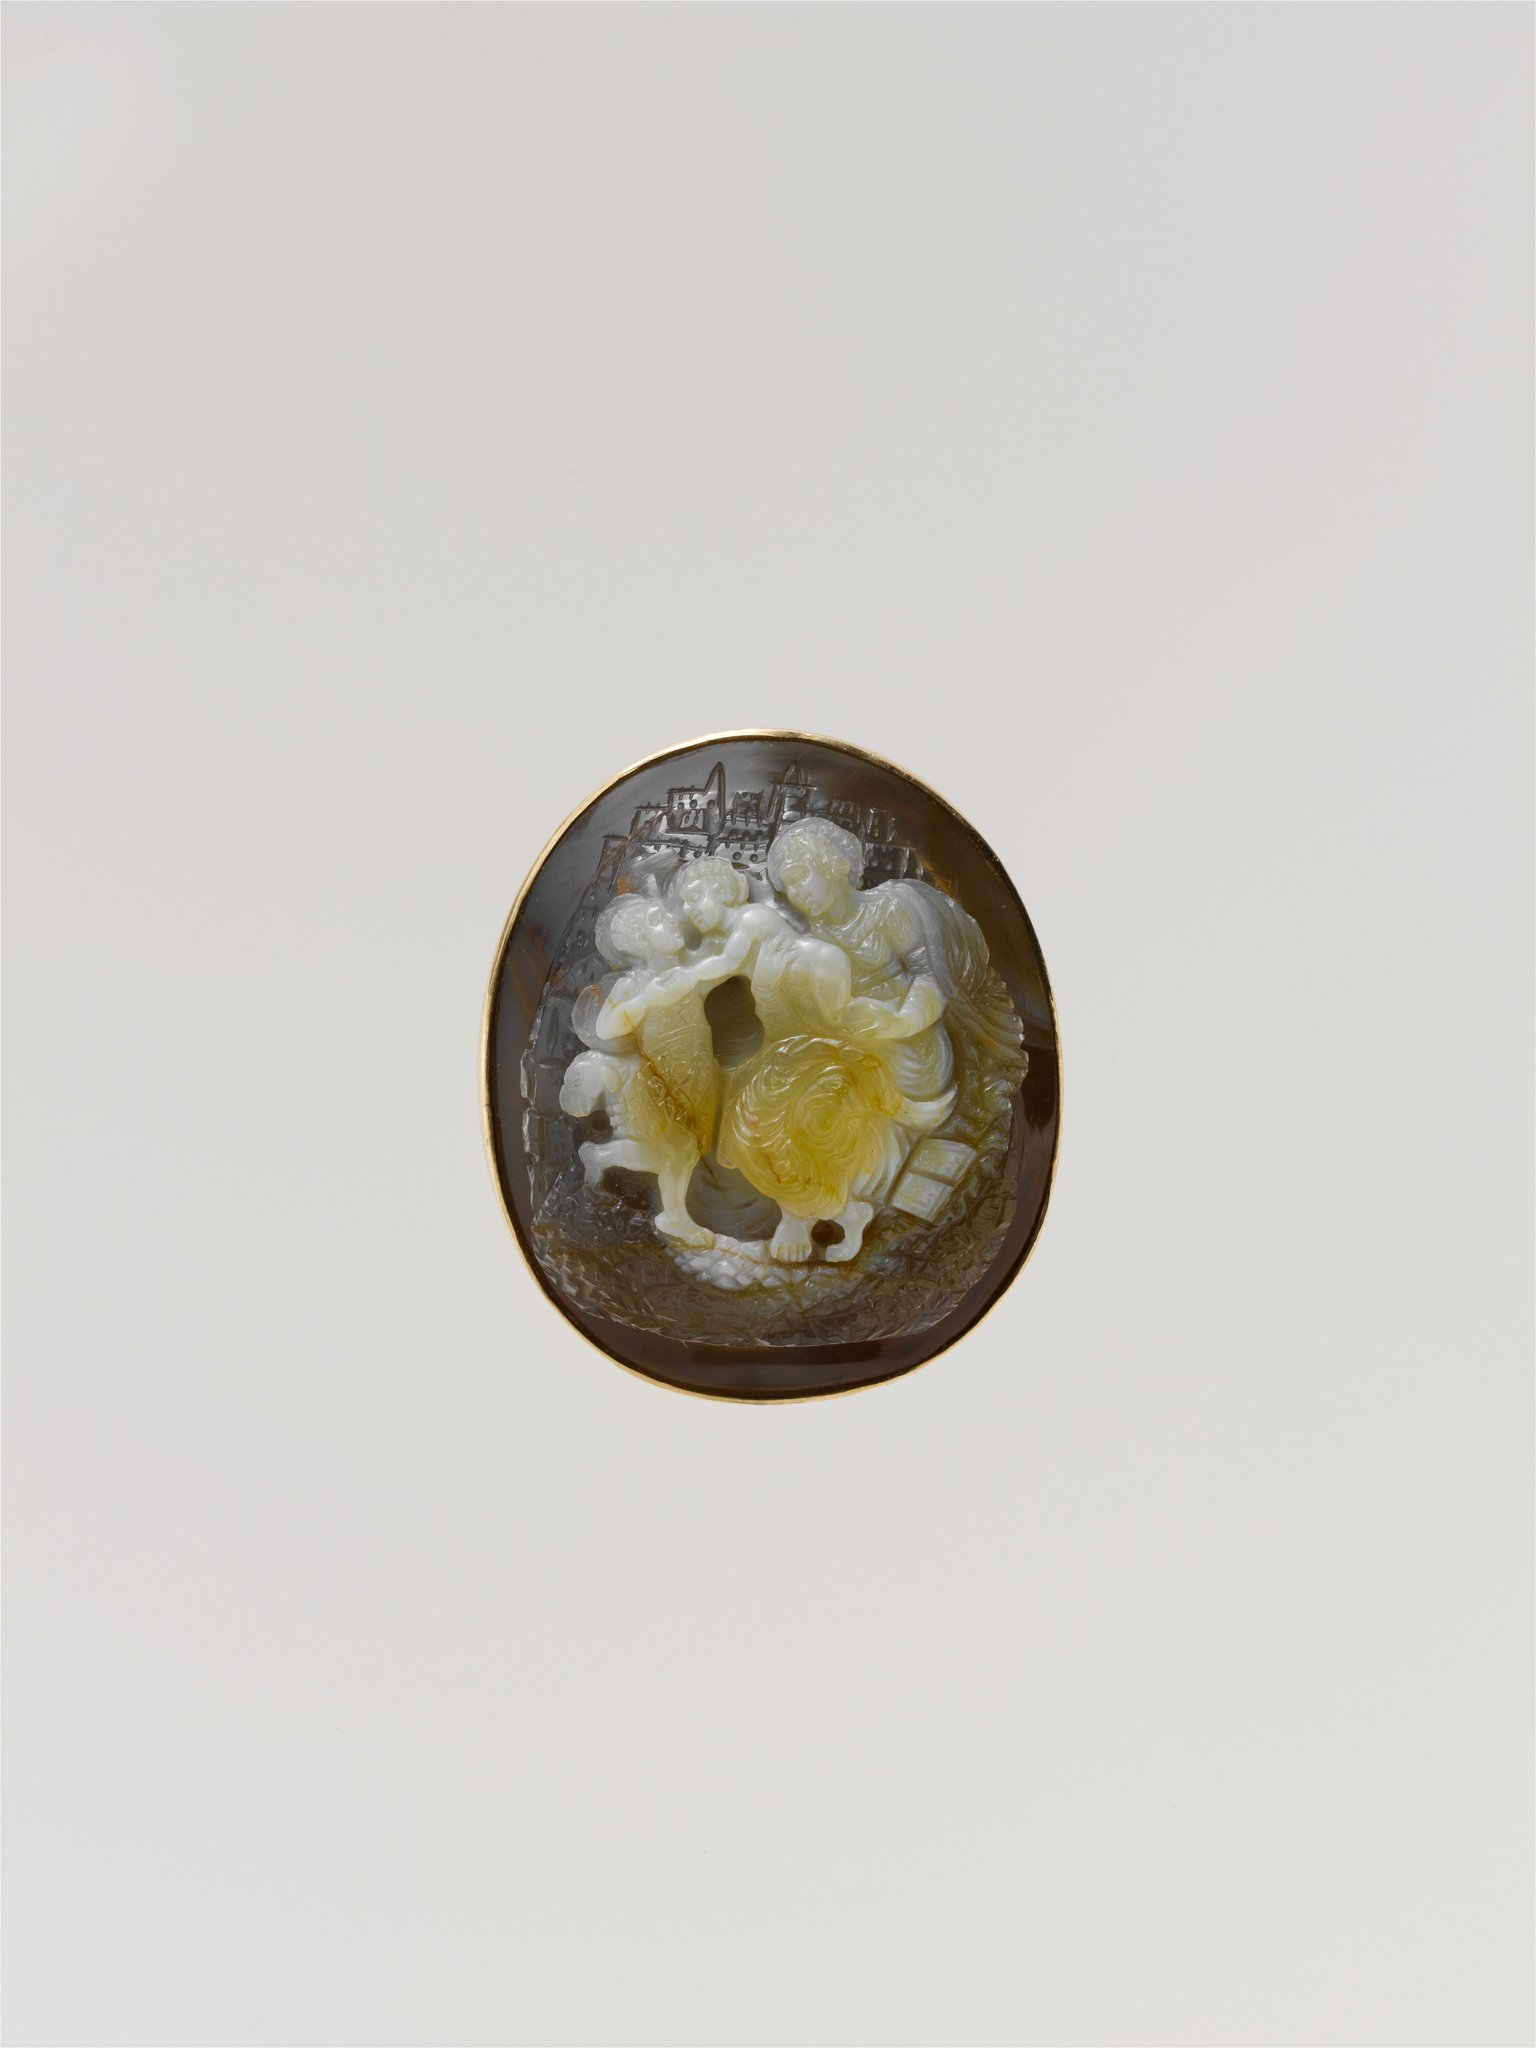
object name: cameo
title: Virgin and Child with Saint John the Baptist in front of a townscape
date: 1520-1530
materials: gold, gemstone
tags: madonna and child,saint john the baptist